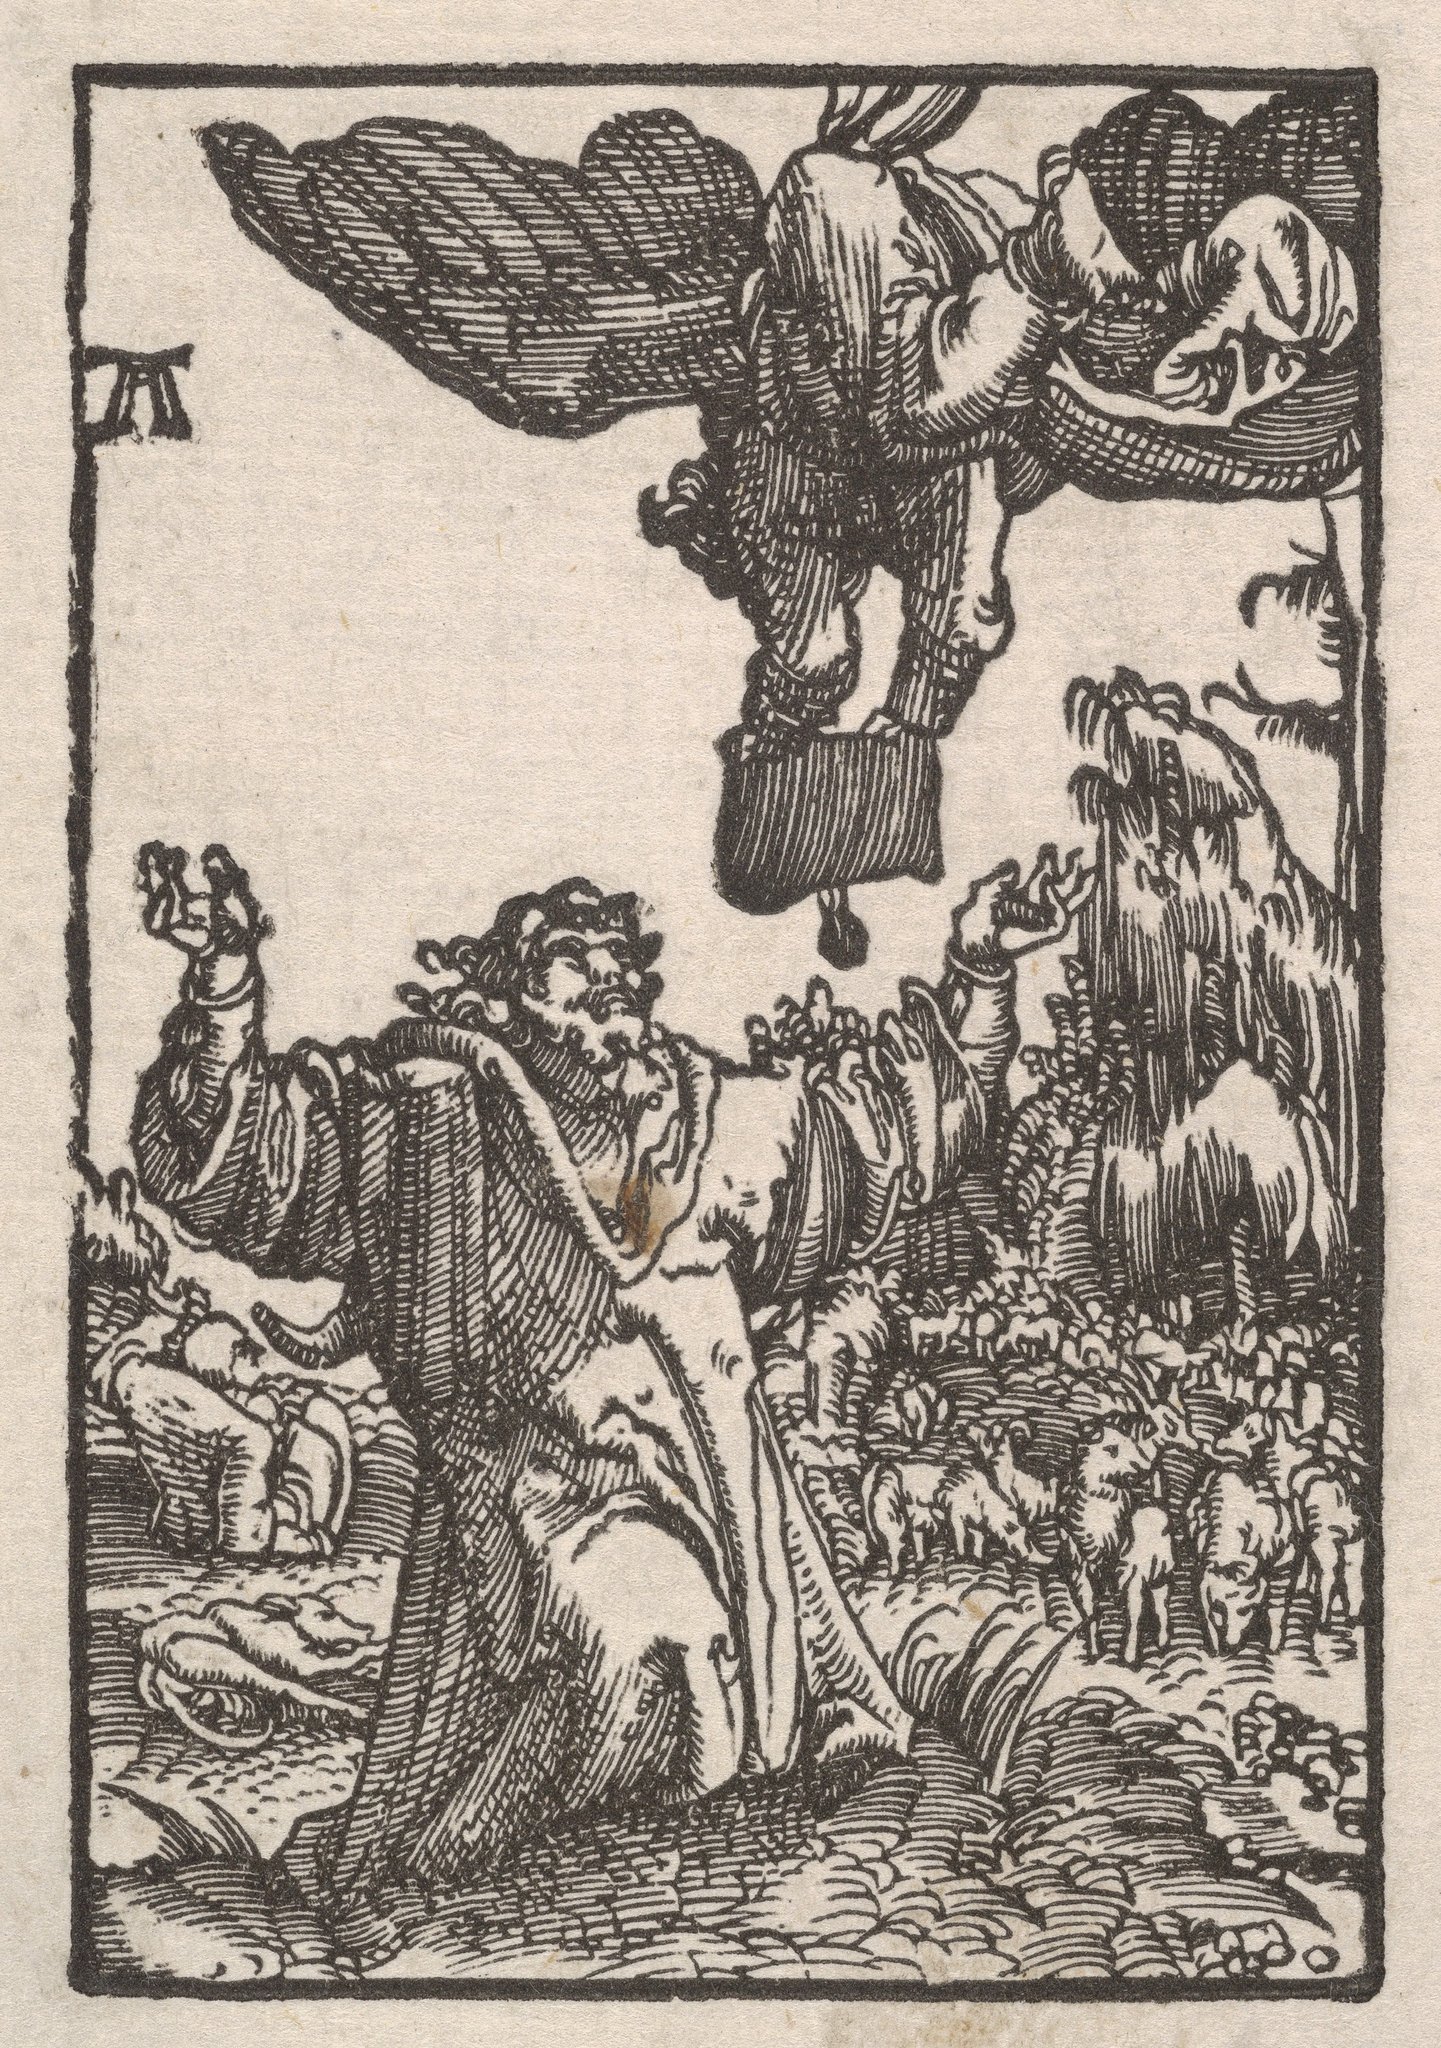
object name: print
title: Annunciation of the Birth of the Virgin to Joachim, from "The Fall and Salvation of Mankind Through the Life and Passion of Christ"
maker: albrecht altdorfer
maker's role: artist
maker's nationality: german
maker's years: 1480-1538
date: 1513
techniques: woodcut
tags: angels,saints